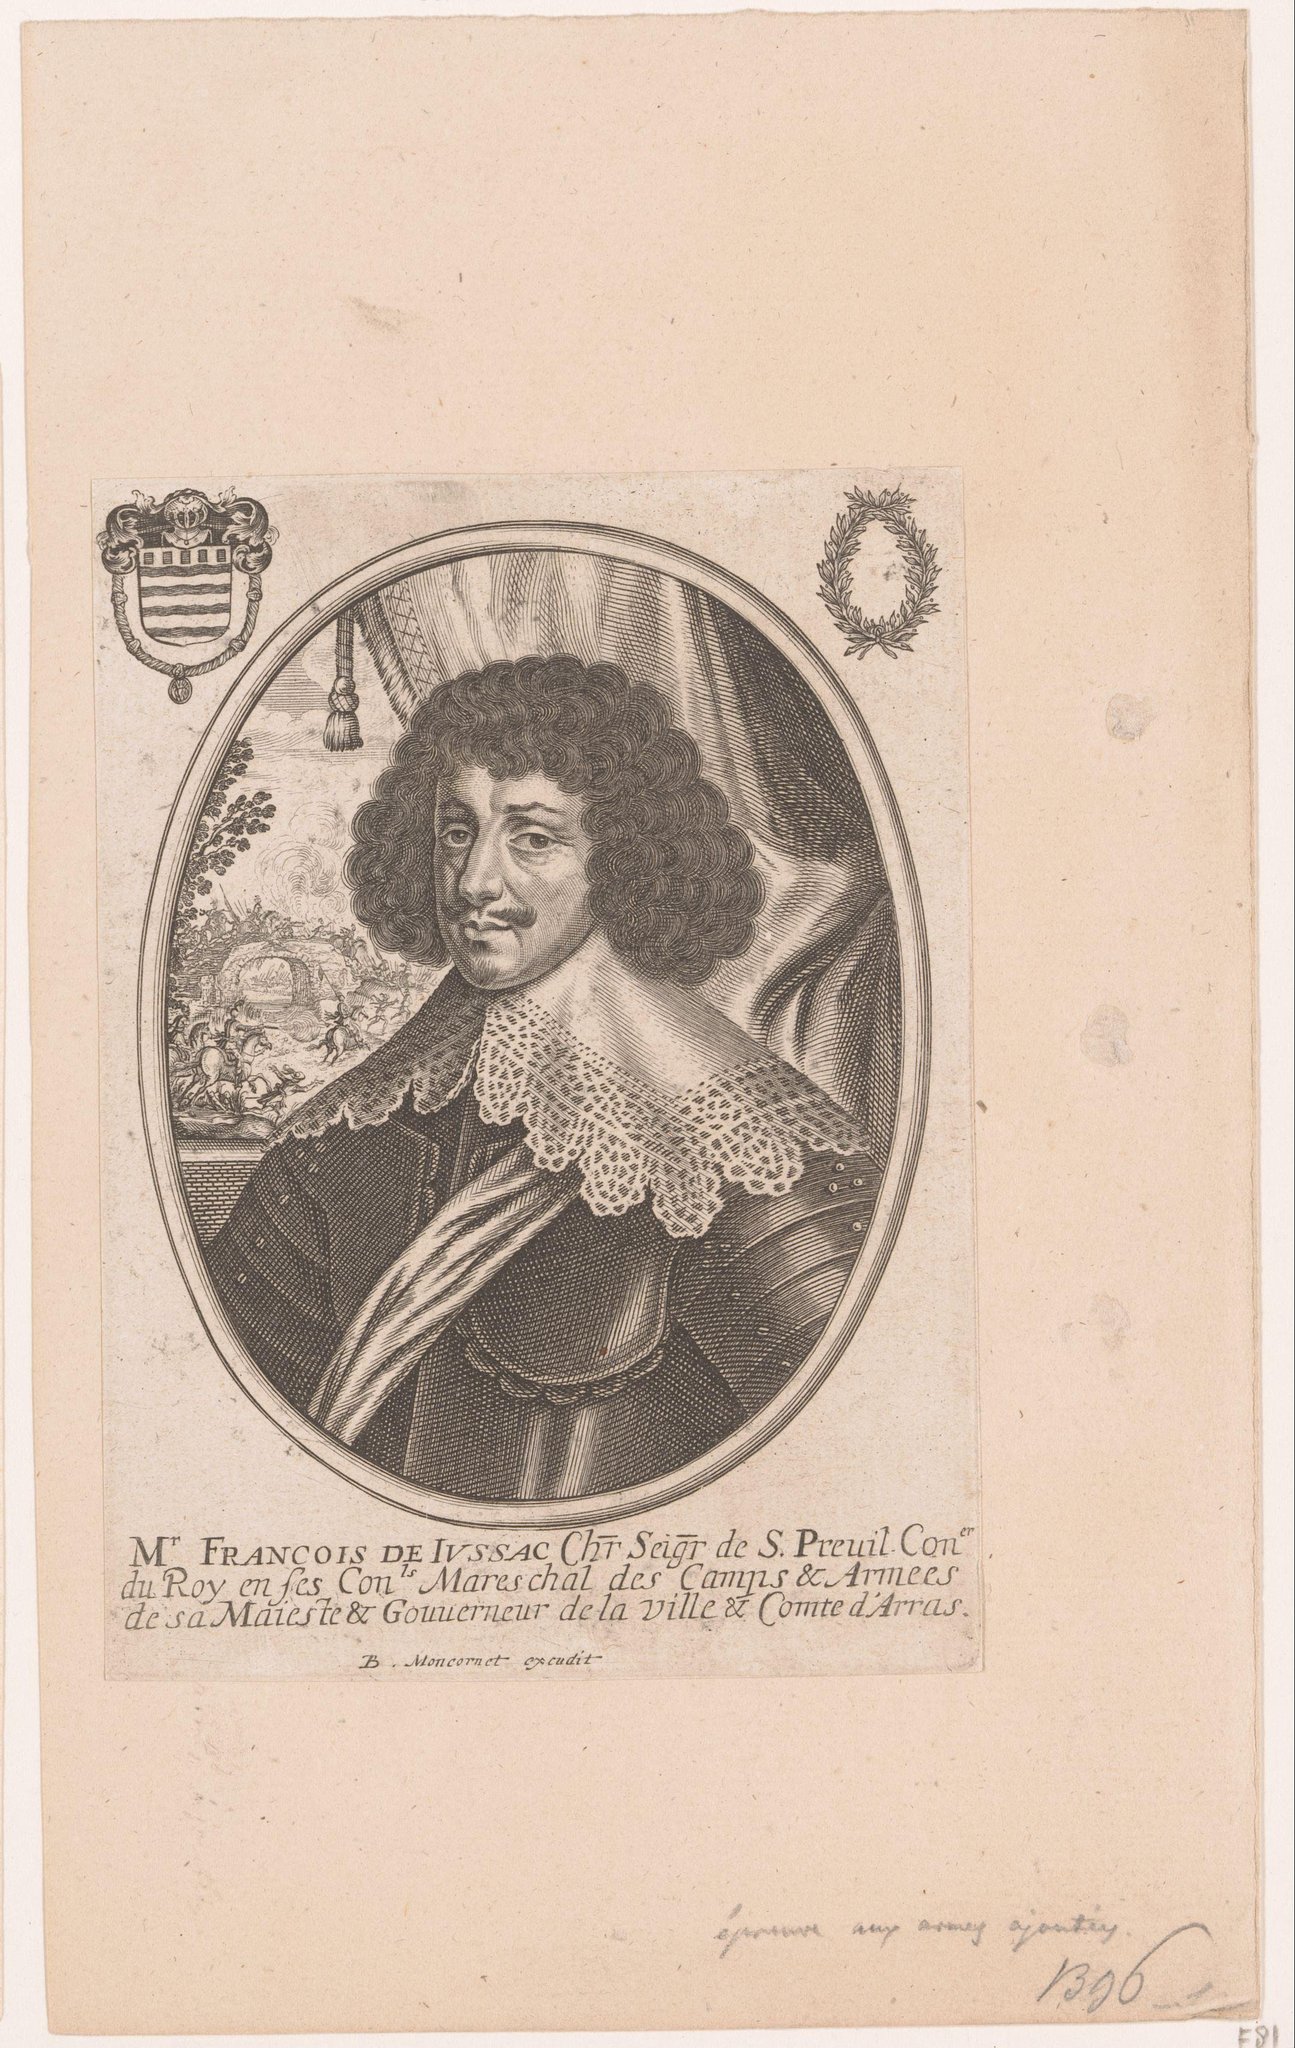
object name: print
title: Portret van François de Jussac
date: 1639-1668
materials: paper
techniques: engraving, etching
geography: paris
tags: ranks in the army, historical persons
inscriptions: collector's mark: Lugt 2228